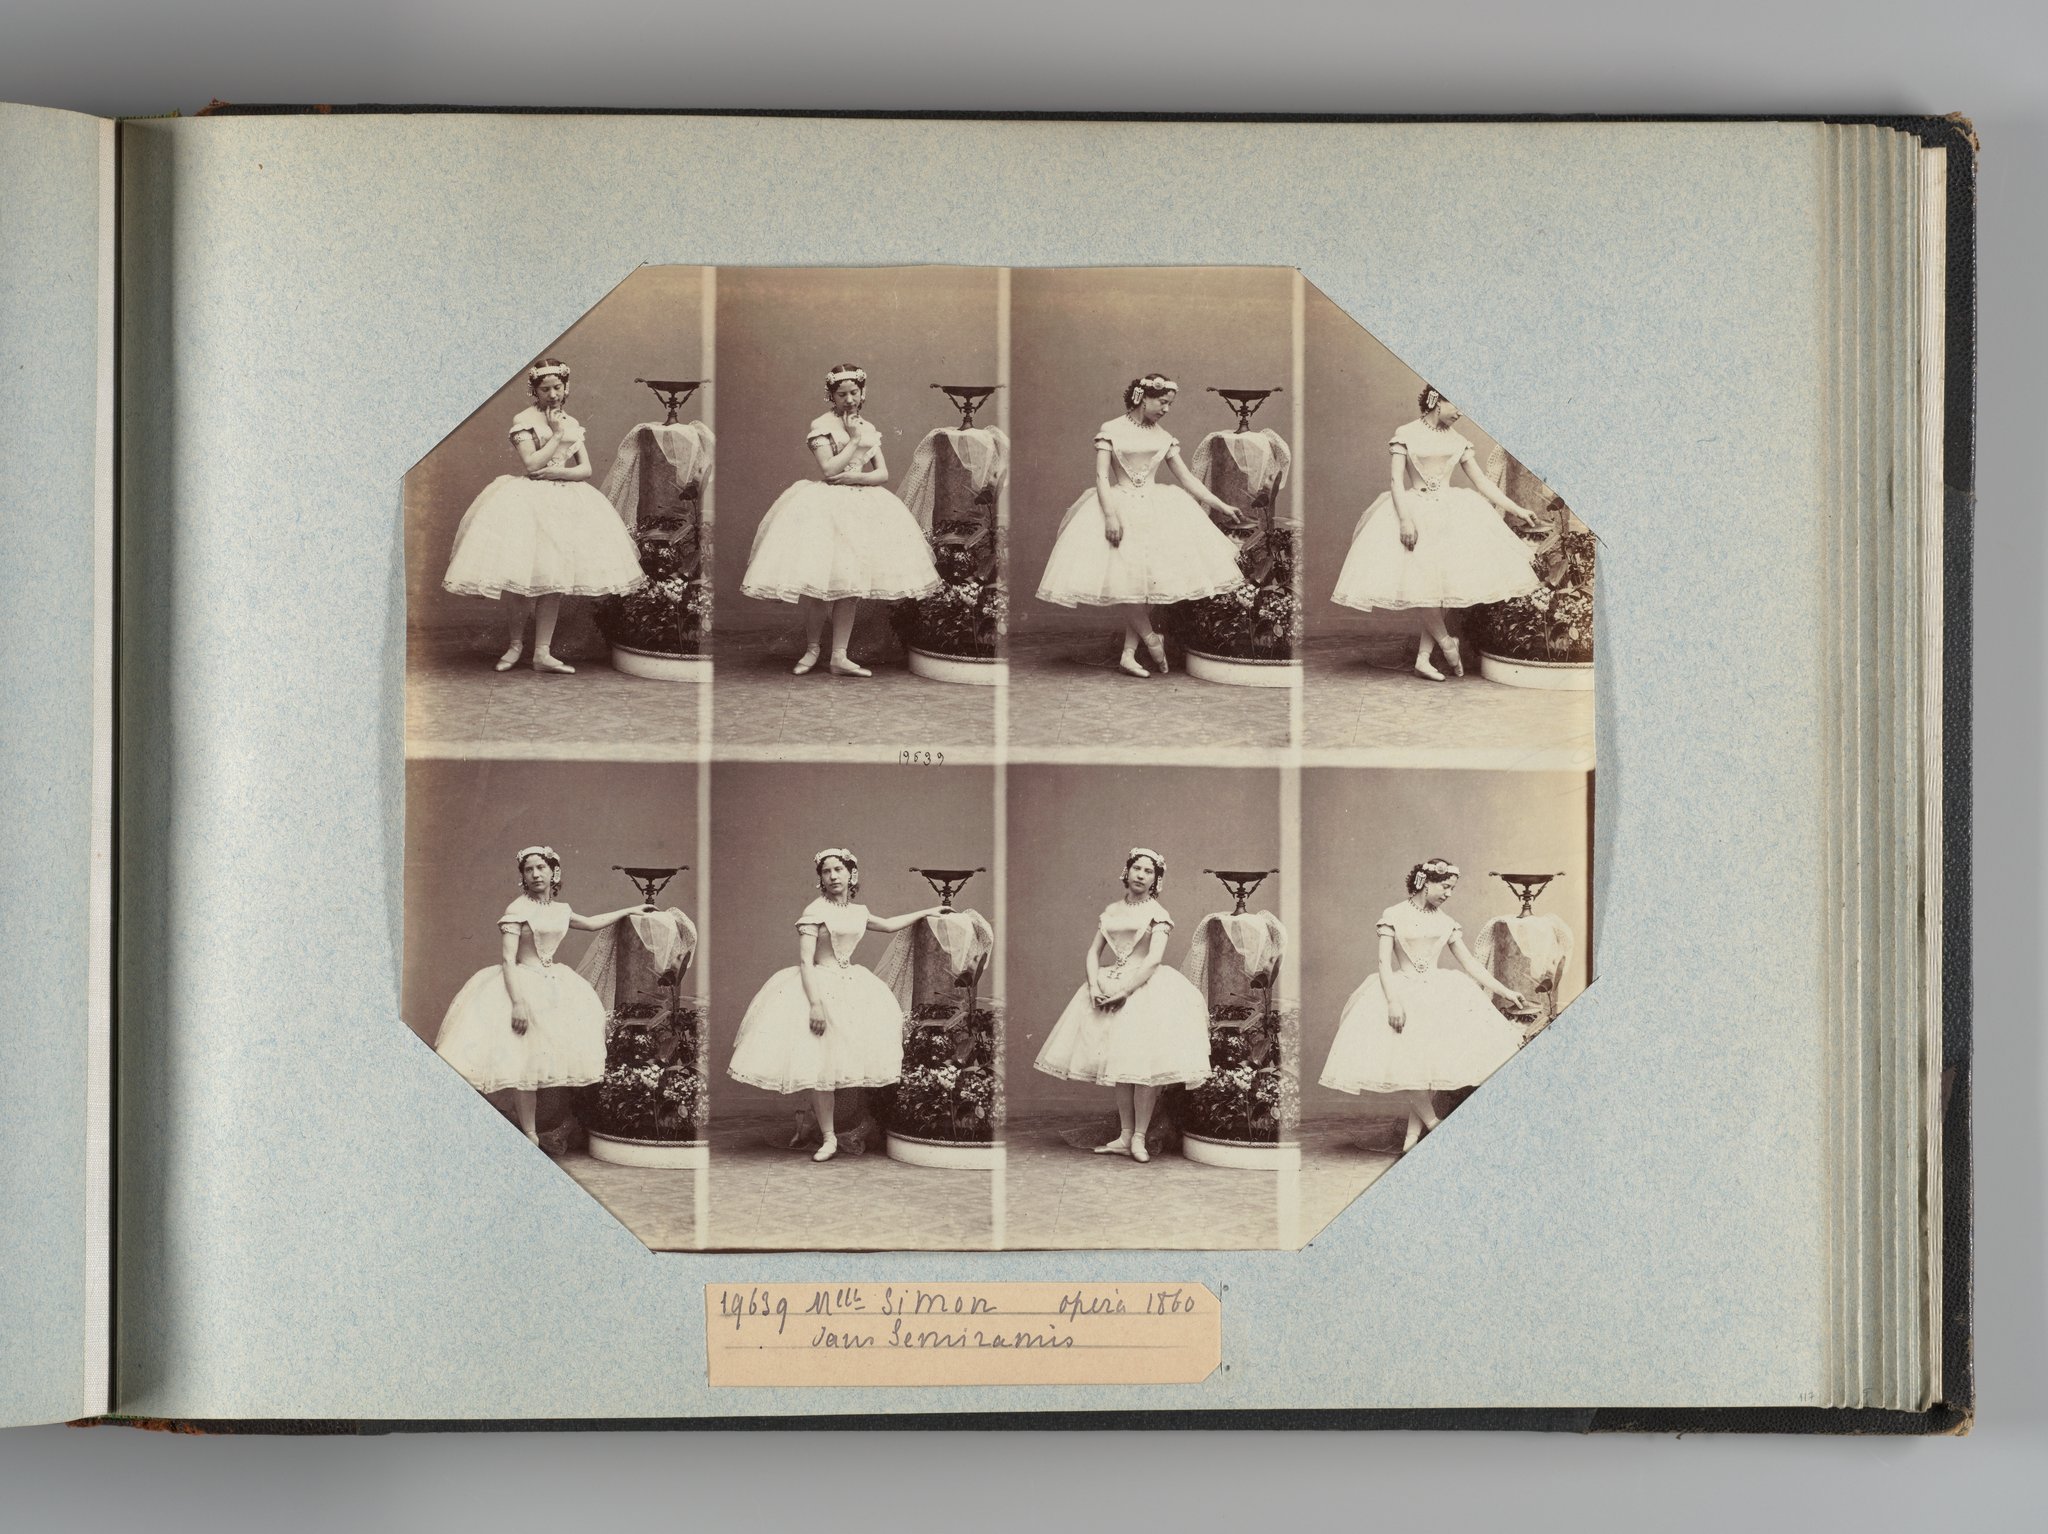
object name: photograph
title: Mlle Simon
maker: andré-adolphe-eugène disdéri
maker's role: artist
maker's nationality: french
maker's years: 1819-1889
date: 1860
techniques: albumen silver print, glass negative